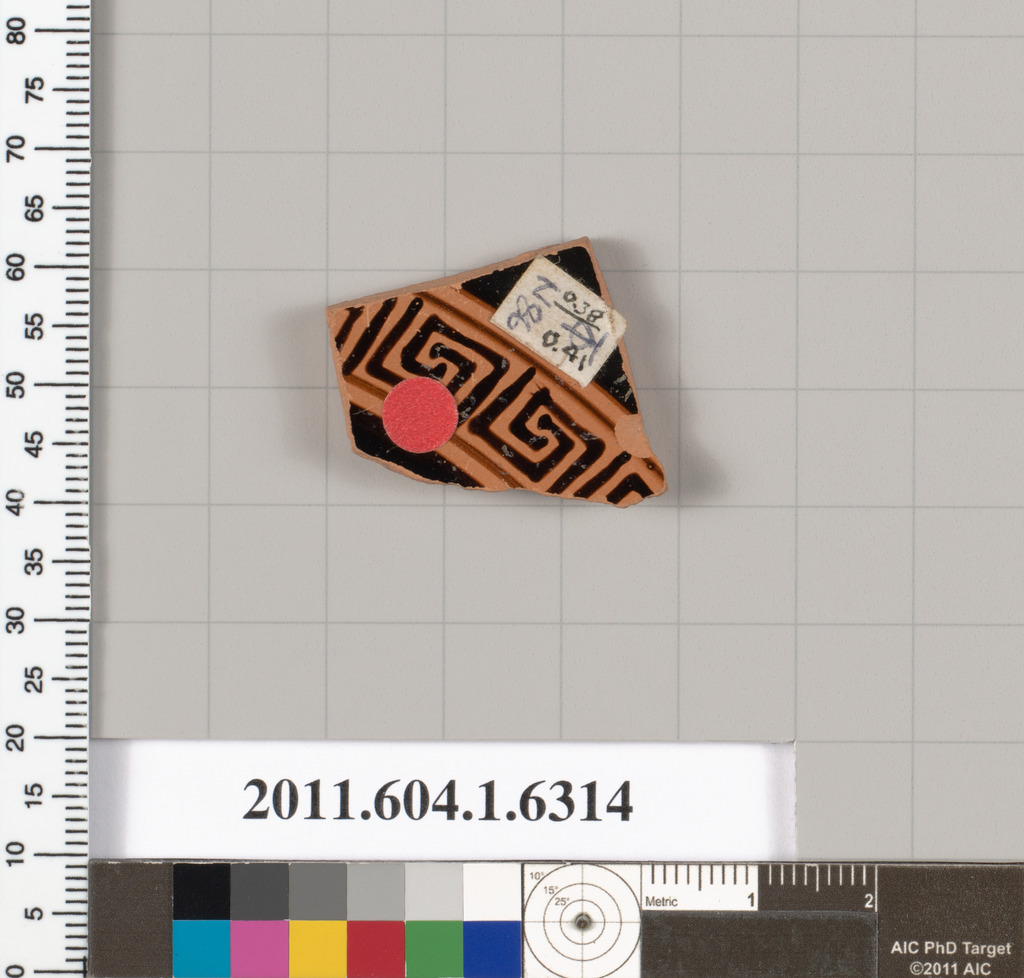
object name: kylix fragment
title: Terracotta fragment of a kylix (drinking cup)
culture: greek, attic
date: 500-480 BCE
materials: terracotta